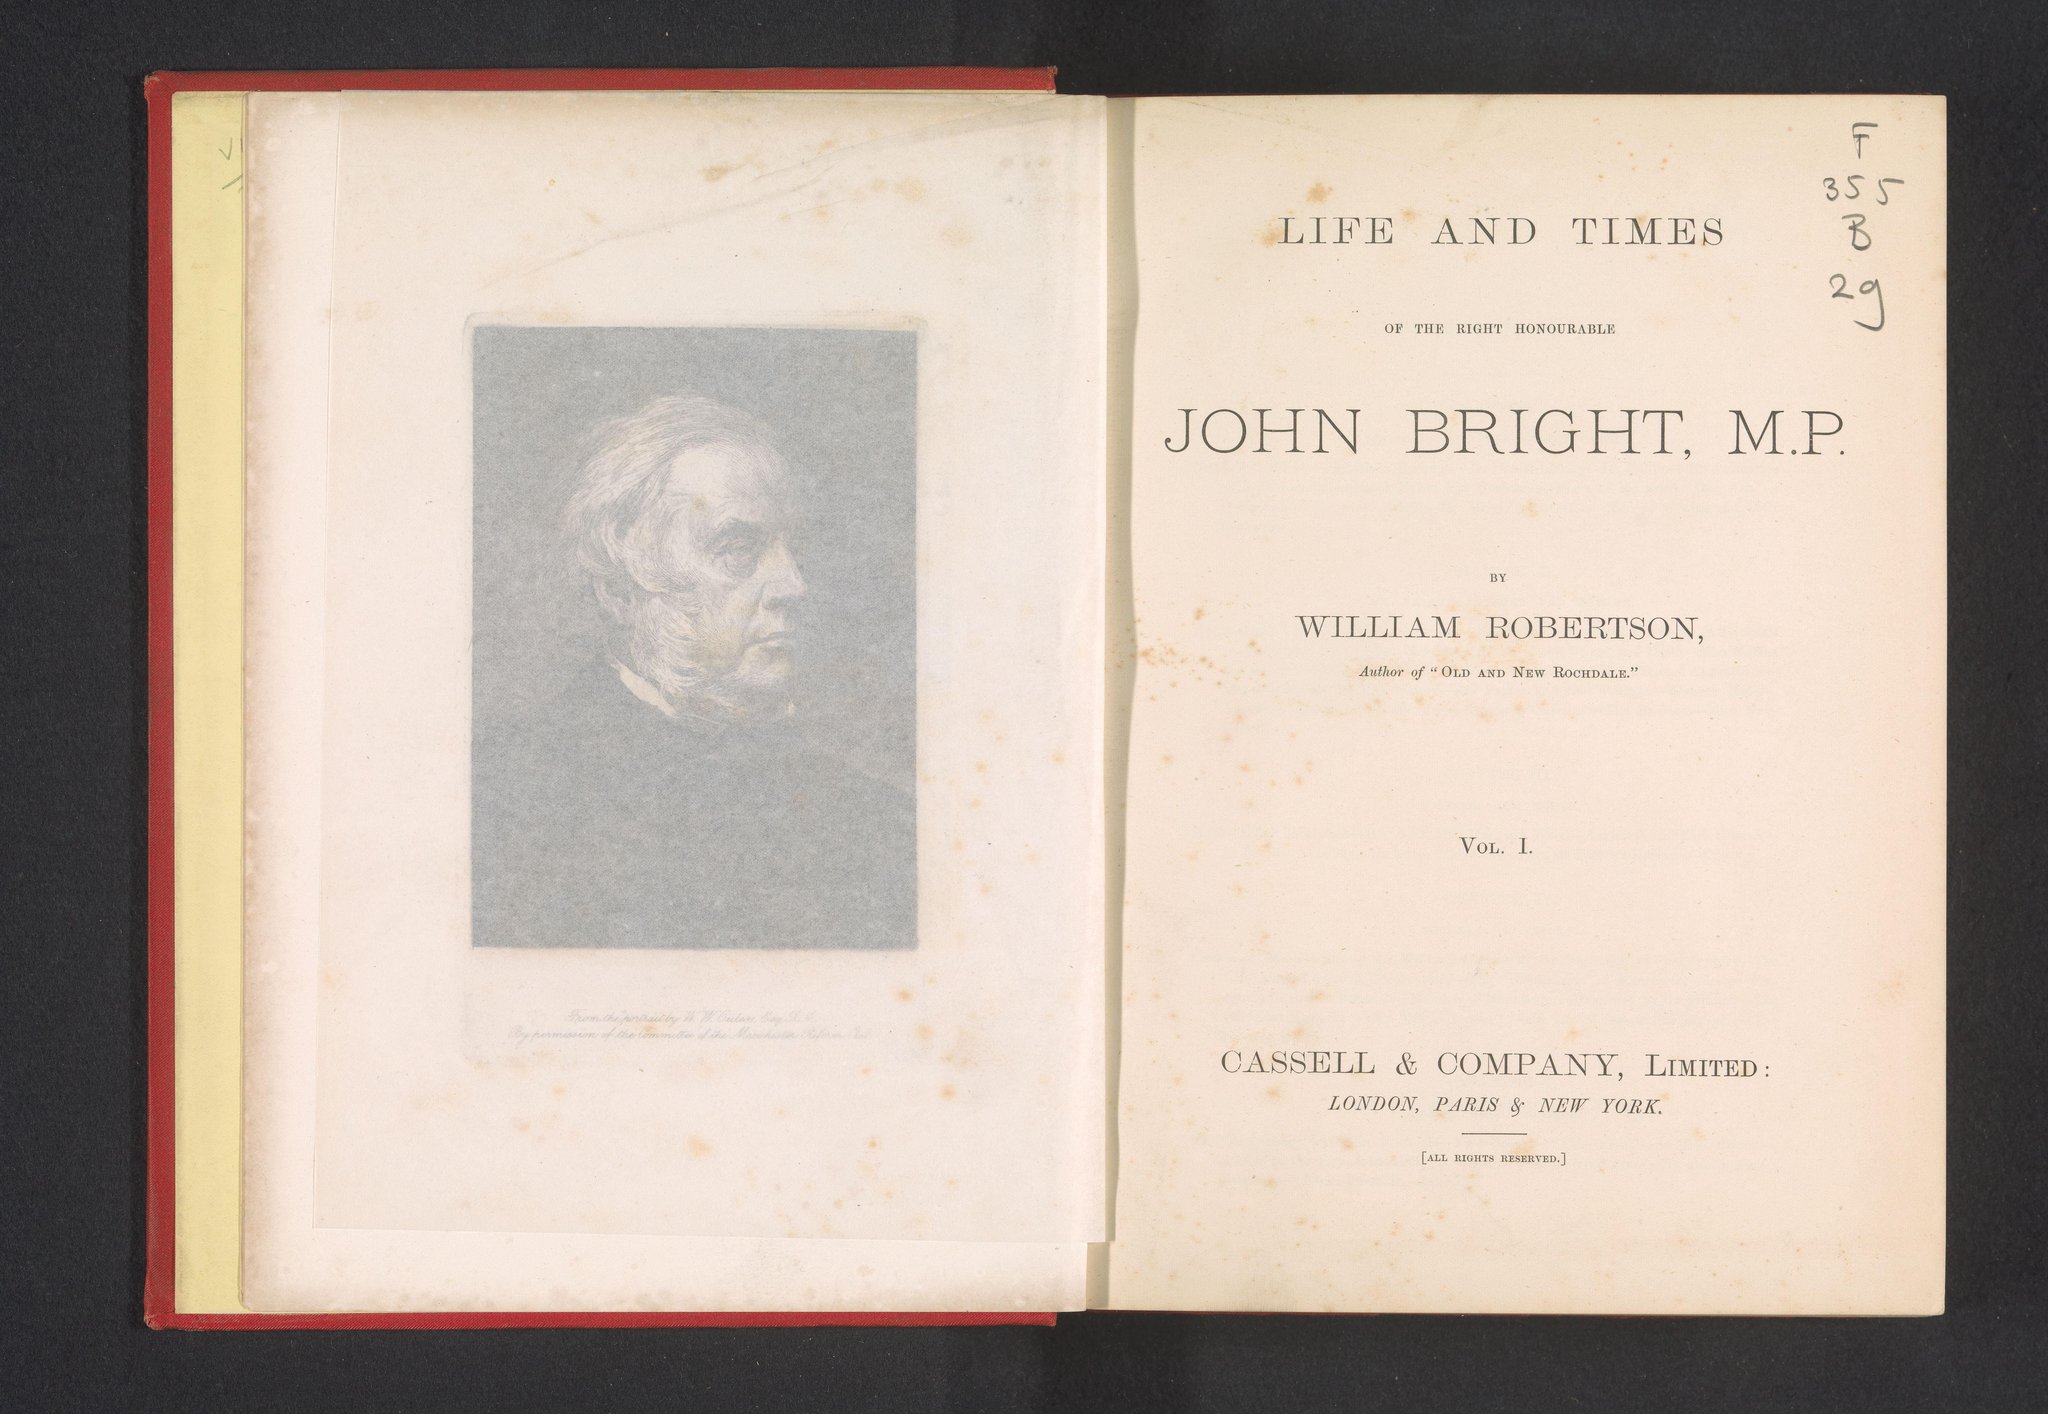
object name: book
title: Life and times of the right honourable John Bright, MP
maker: william robertson (auteur)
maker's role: auteur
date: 1884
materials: linen, paper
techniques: printing, woodburytype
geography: london